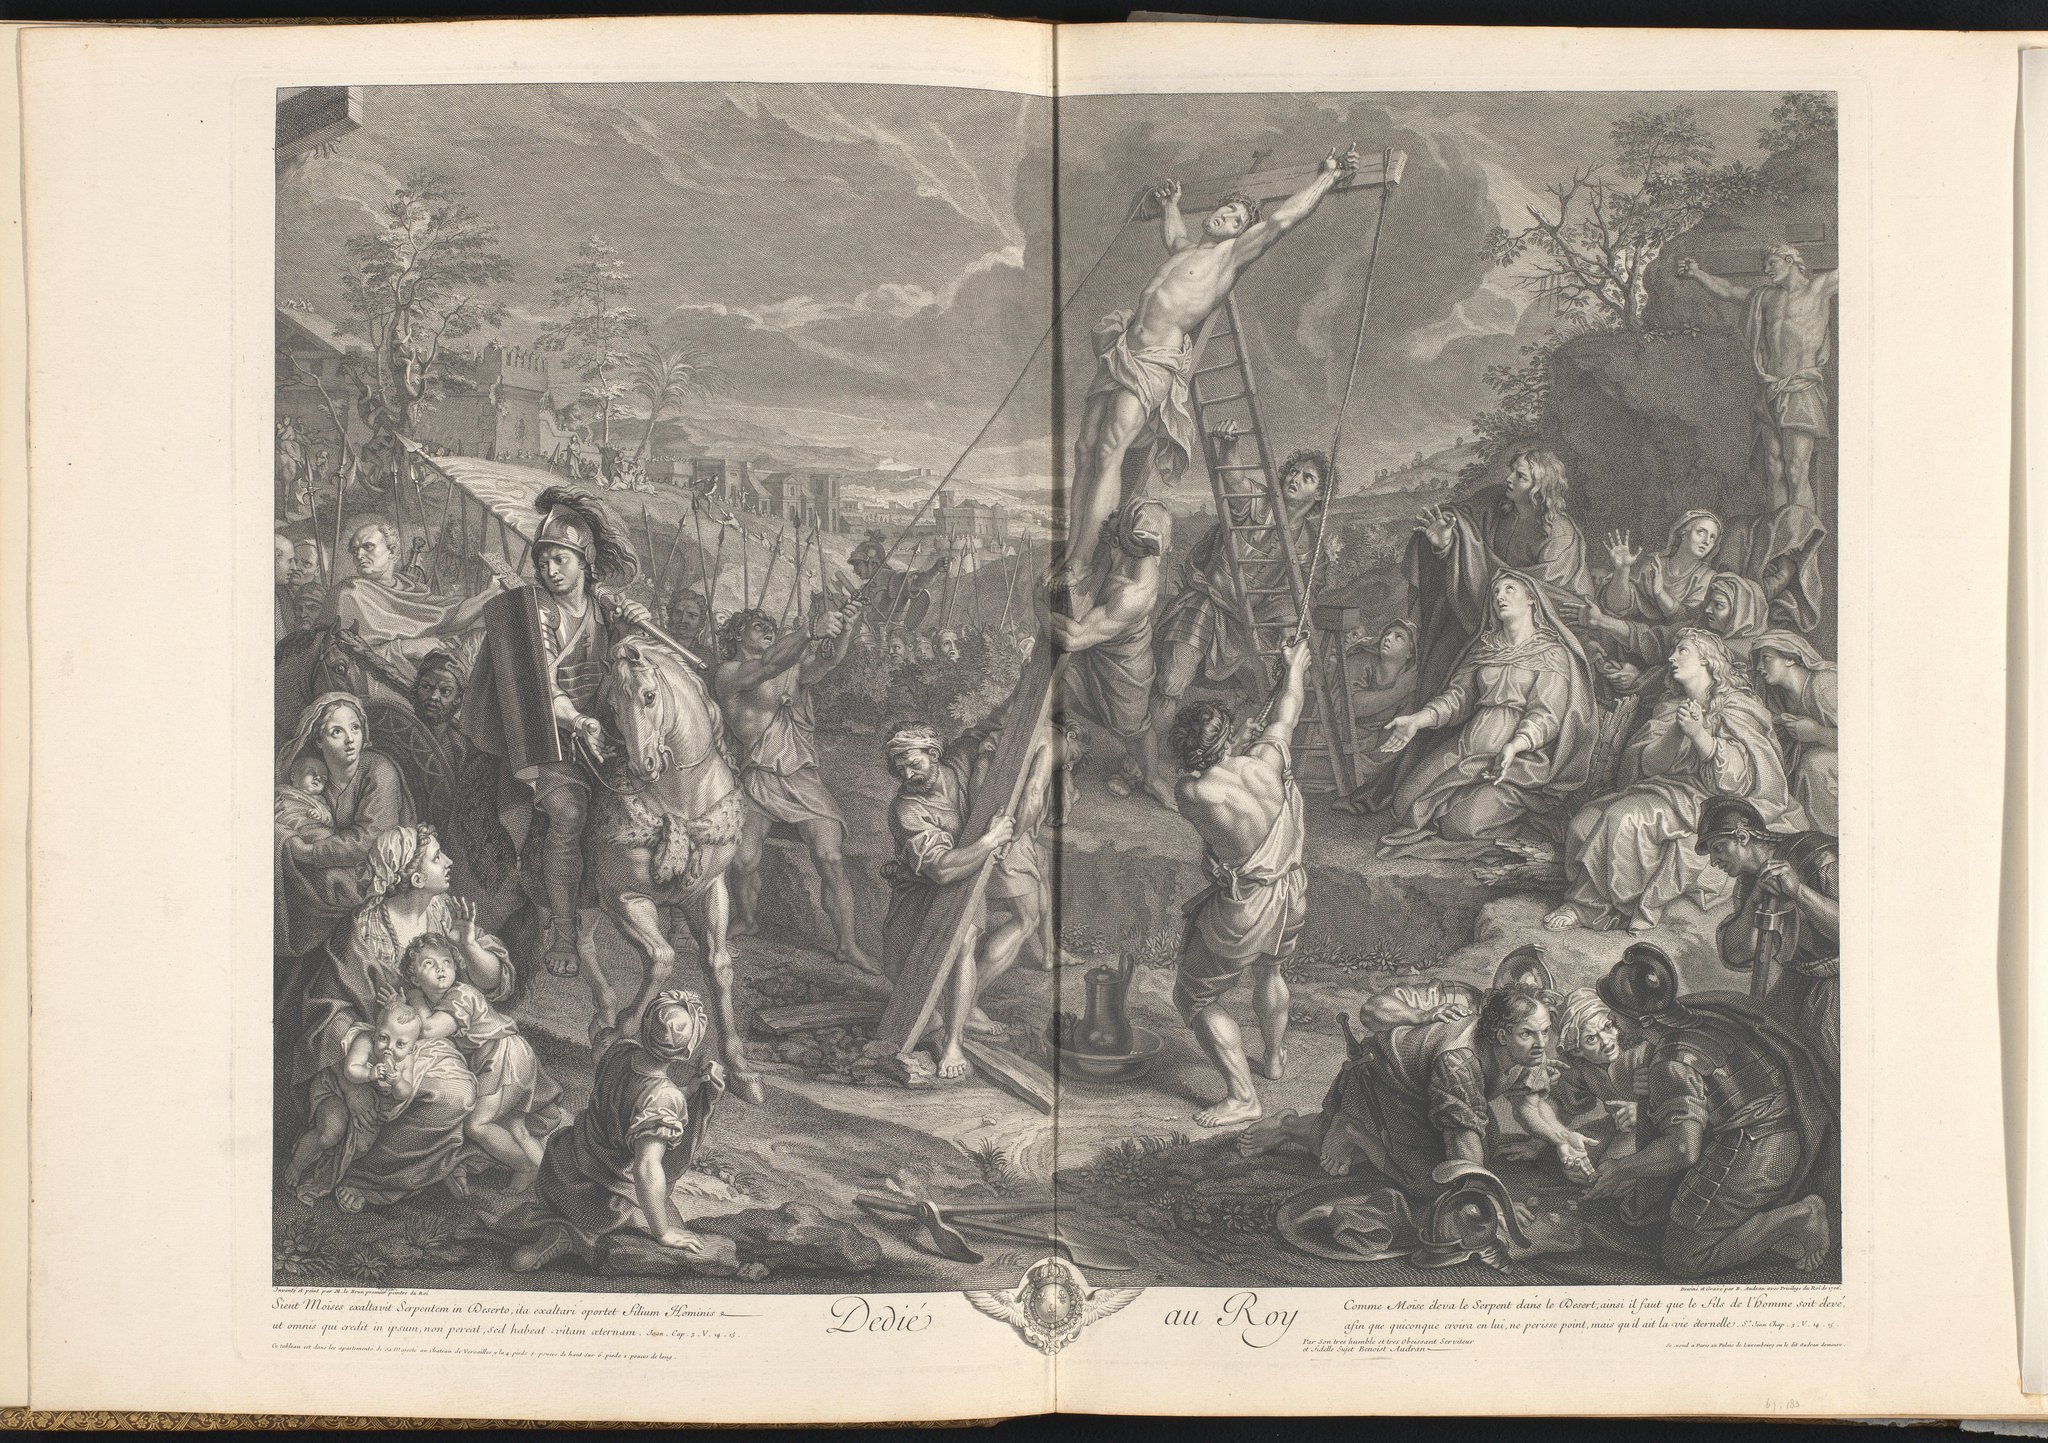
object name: album leaf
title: Oprichting van het kruis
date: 1706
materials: paper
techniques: engraving, etching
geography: paris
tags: raising of the cross to which christ is nailed already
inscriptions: date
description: Deze prent maakt deel uit van een album.